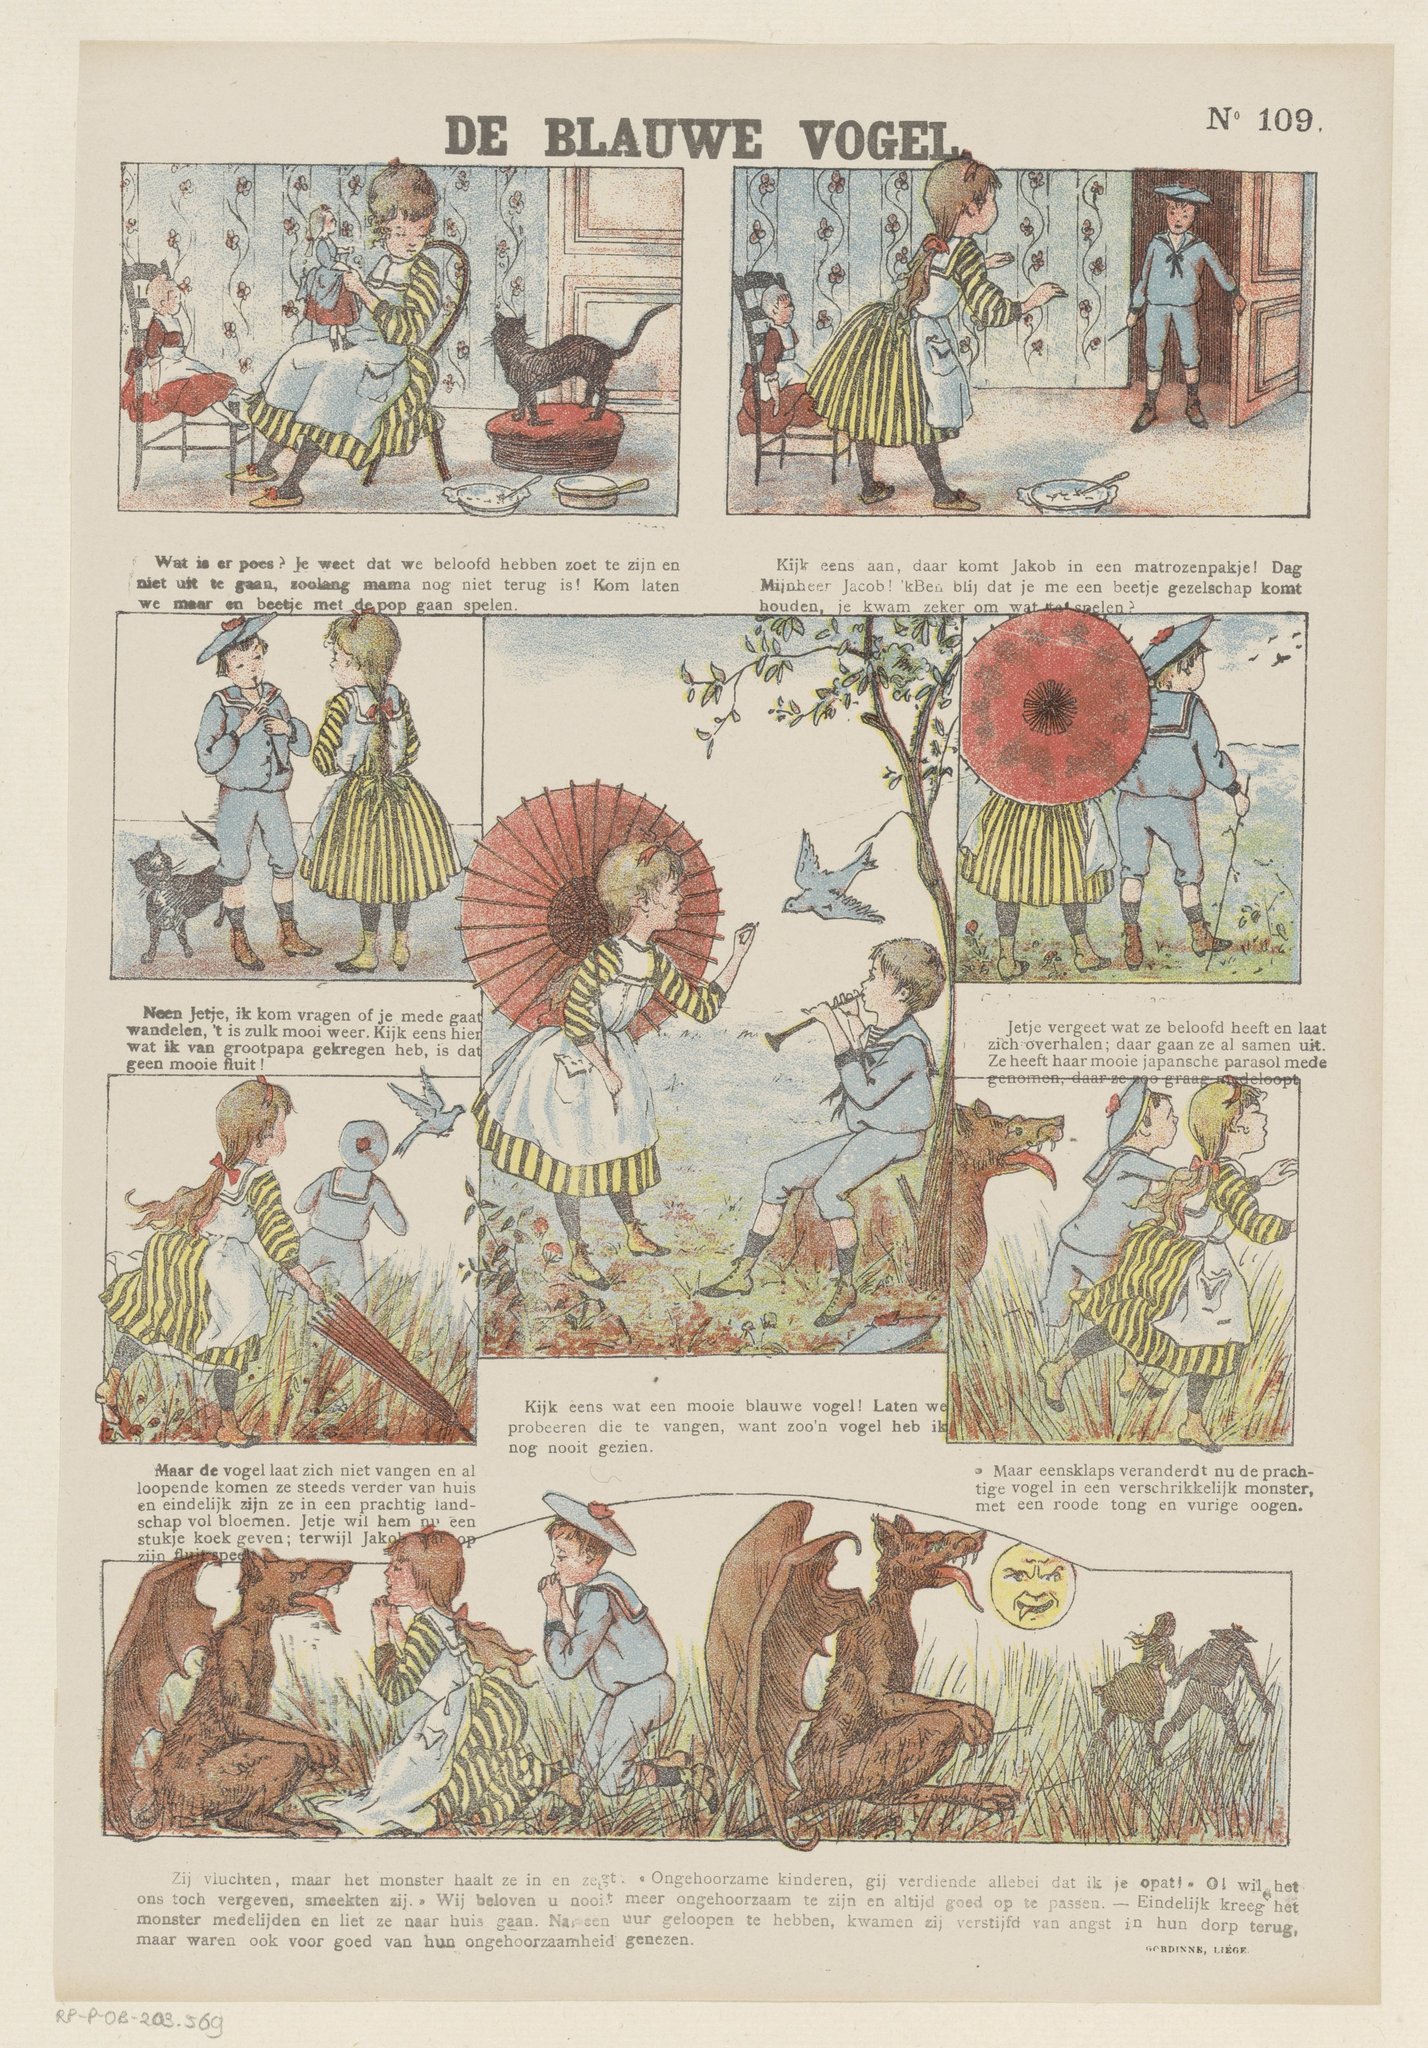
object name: print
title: De blauwe vogel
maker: Anonymous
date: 1894-1959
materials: paper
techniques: lithograph, letterpress printing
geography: liège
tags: ornamental birds (+ animal(s) being hit, shot, caught), bad behaviour, (playing with) dolls, mis-shapen animals; monsters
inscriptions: collector's mark: Lugt 2760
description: Blad met 8 voorstellingen over twee ongehoorzame kinderen die een vogel achterna zitten. Plotseling verandert de vogel in een monster en leert de kinderen een wijze les. Onder elke afbeelding een onderschrift. Genummerd rechtsboven: No 109.